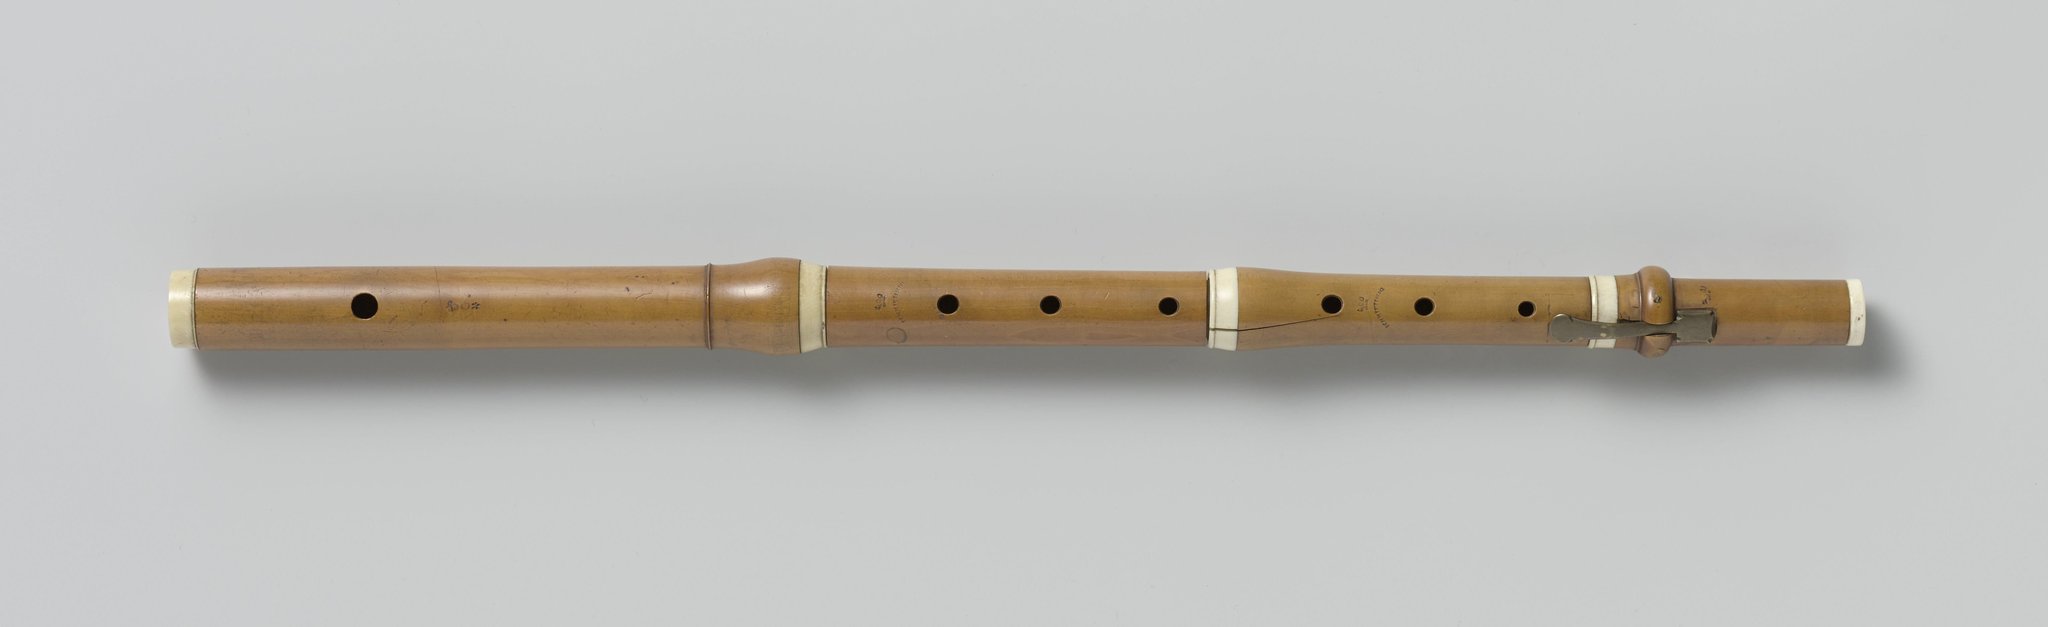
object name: musical instrument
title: Flute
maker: johannes christiani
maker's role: musical instrument maker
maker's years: 1745-1816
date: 1810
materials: wood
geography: amsterdam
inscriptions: stamp: ‘I:CHRISTIANI’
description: Dwarsfluit met een klep. Gemerkt: I. Christiani.